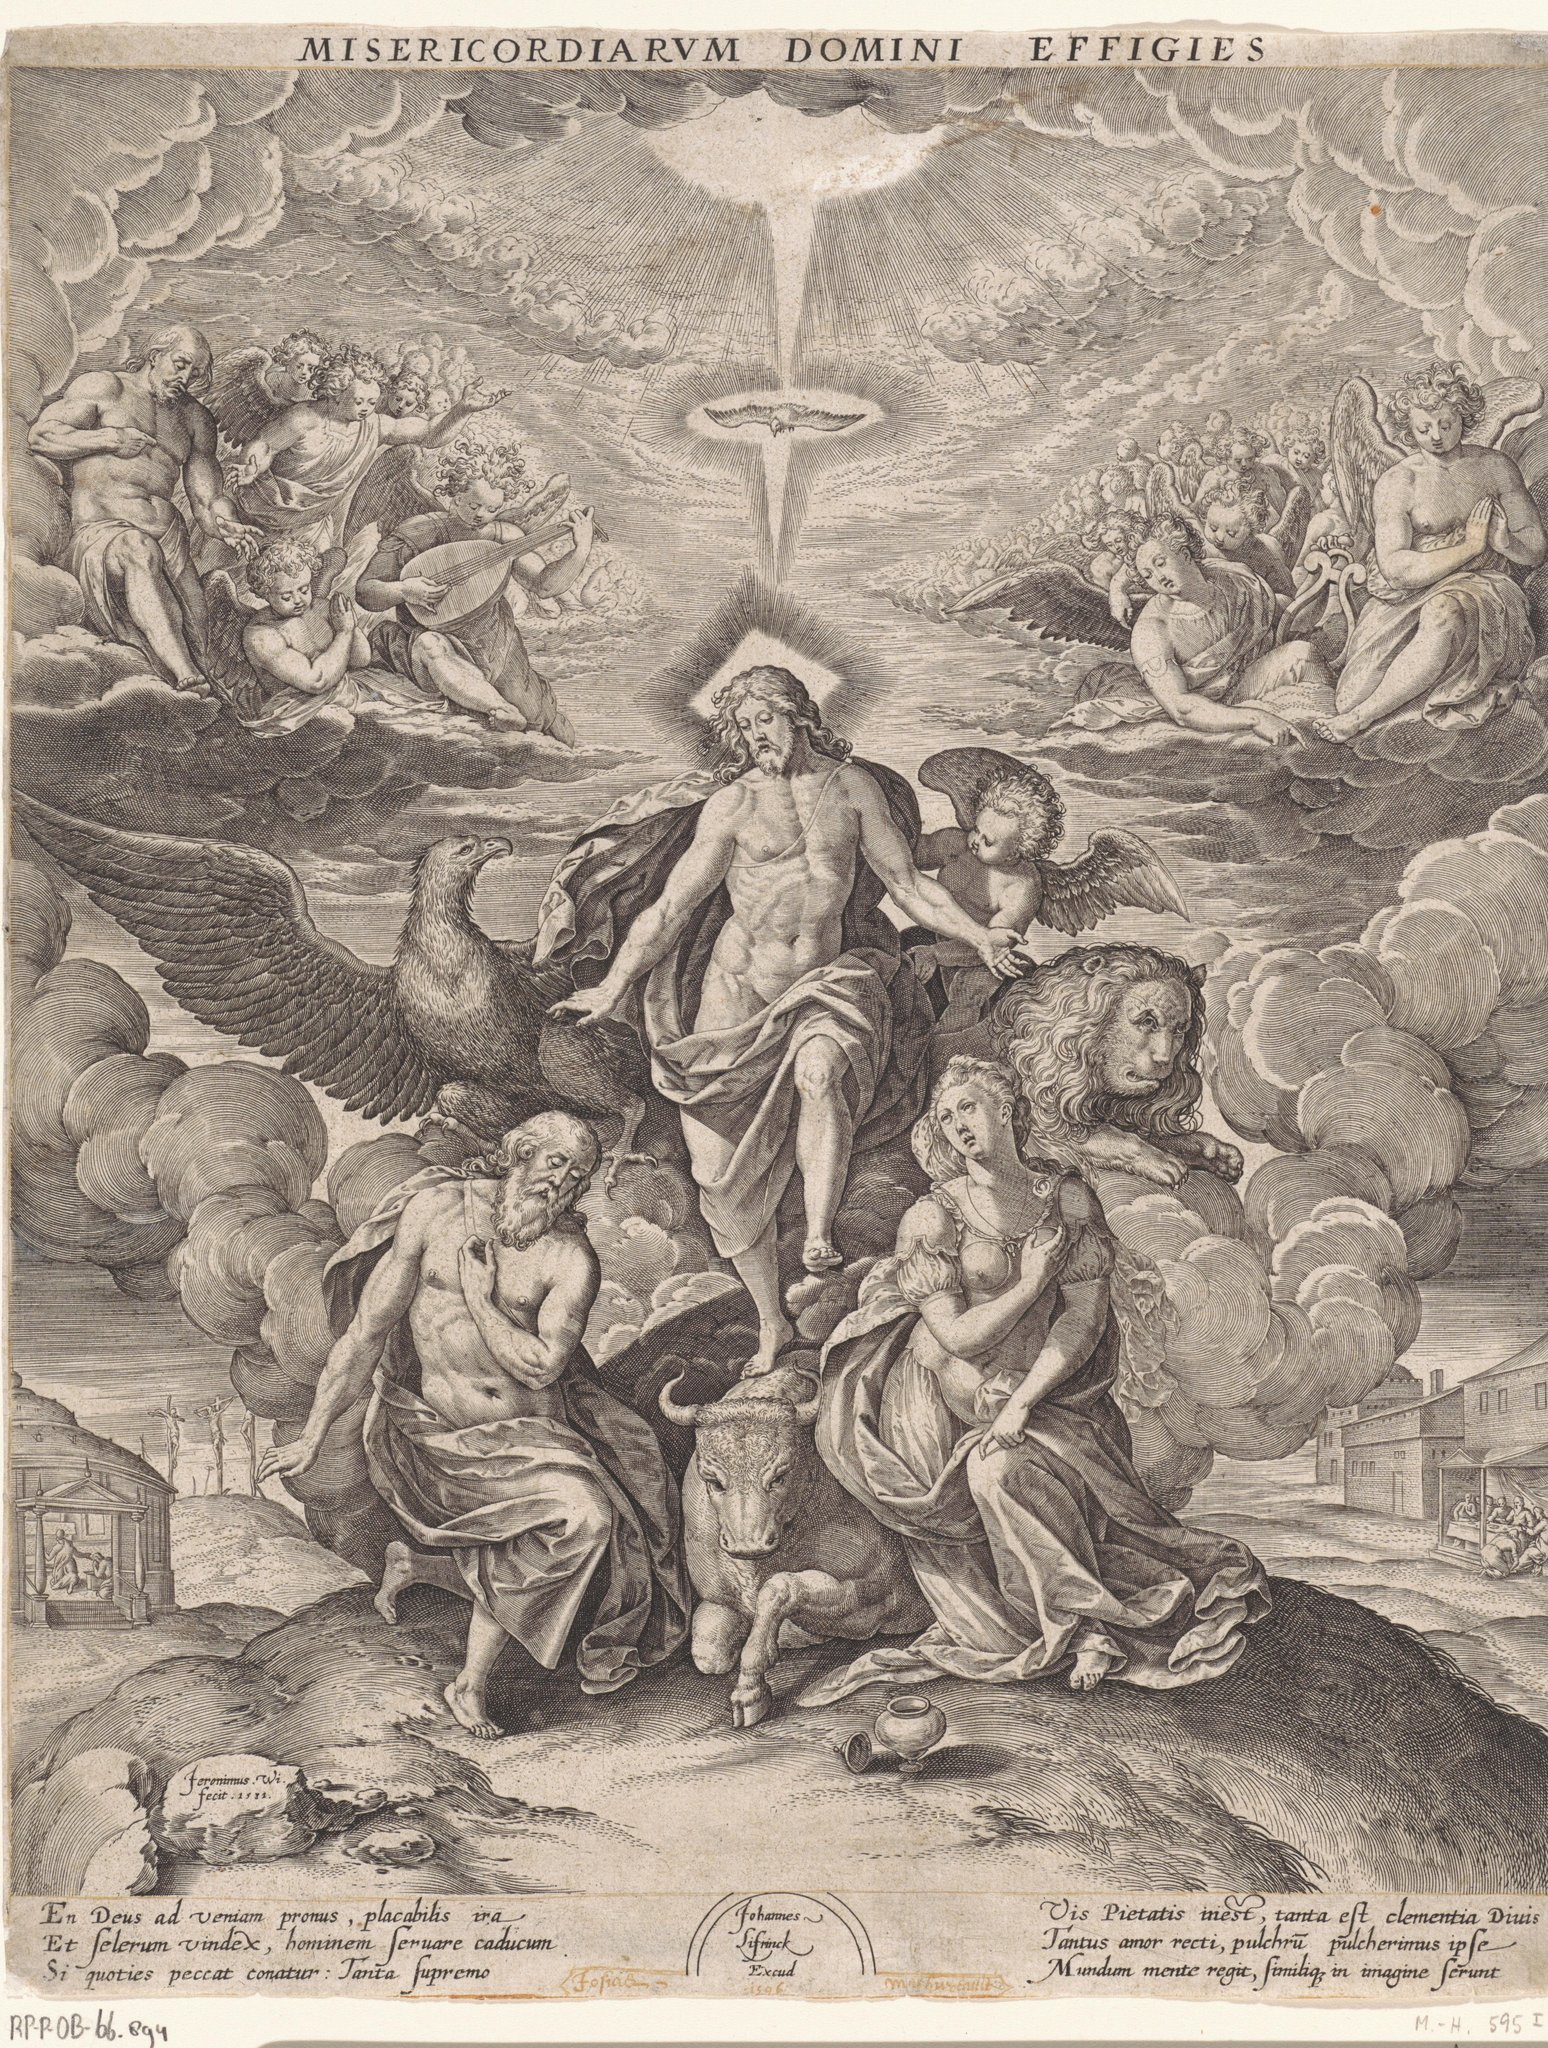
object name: print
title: Misericordiarvm domini effigies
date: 1581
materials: paper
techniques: engraving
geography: antwerp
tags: types of adult christ (alone), the praying pharisee and the repentant publican in the temple (luke 18:10-14), the four symbols of the evangelists, 'the apocalyptic beasts', christ's feet are anointed by mary (magdalene), the penitent harlot mary magdalene; possible attributes: book (or scroll), crown, crown of thorns, crucifix, jar of ointment, mirror, musical instrument, palm-branch, rosary, scourge, the three crosses with the crucified, without bystanders, holy ghost represented as a dove (in flames)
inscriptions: name: ‘Jofias 1596 Mathusenuit’, collector's mark: Lugt 2228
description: De barmhartige Christus, omringd door symbolen van de vier evangelisten, strekt zijn handen uit naar de tollenaar en Maria Magdalena. Boven hen in de hemel de Heilige Geest als duif, omringd door musicerende engelen en de heilige Petrus (links op de wolken). Links op de achtergrond de gelijkenis van de farizeeër en de tollenaar. En verder naar de achtergrond de gekruisigde Christus, geflankeerd door de twee misdadigers. Rechts op de achtergrond wast Maria Magdalena de voeten van Christus in het huis van Simon de Farizeeër. In de marge een zesregelig onderschrift, in twee kolommen, in het Latijn.